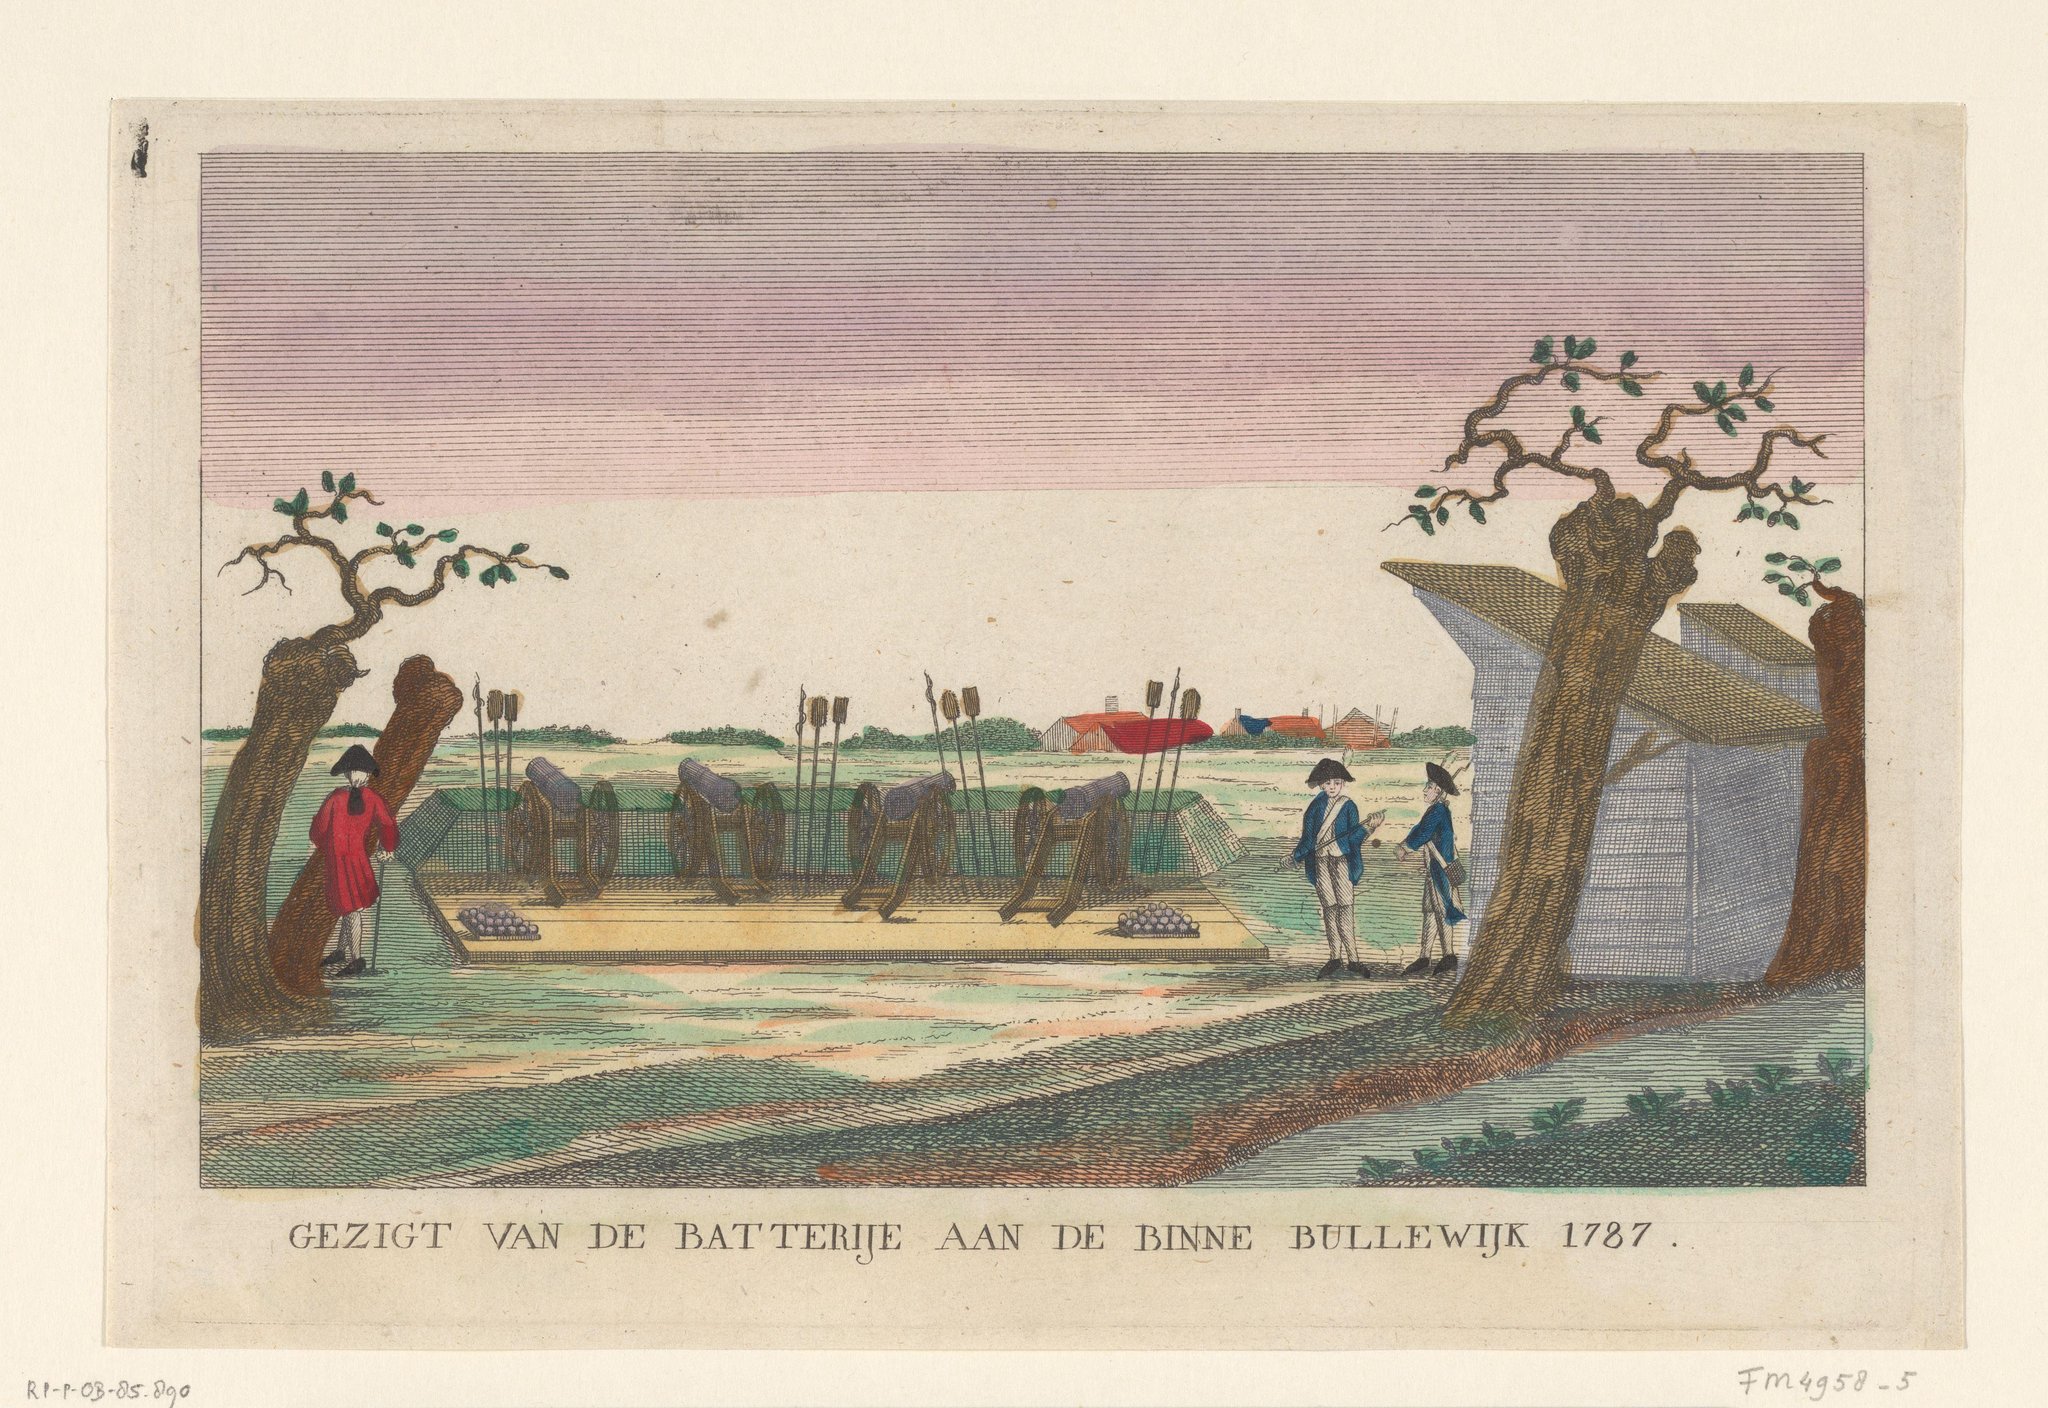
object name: print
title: Gezigt van de batterije aan de Binne Bullewijk 1787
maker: Anonymous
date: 1787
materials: paper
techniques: etching, hand coloring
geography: augsburg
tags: defence of fortification or city, defensive measures (military)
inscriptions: collector's mark: Lugt 2228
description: Battterij aan de Binnen Bullewijk. Onderdeel van een serie van drie (van de mogelijk veertien) Duitse platen gekopieerd naar de reeksen van veertien platen van de verdedigingen aangelegd door de patriotten rondom Amsterdam ten tijde van de inval van de Pruisische troepen in september 1787.